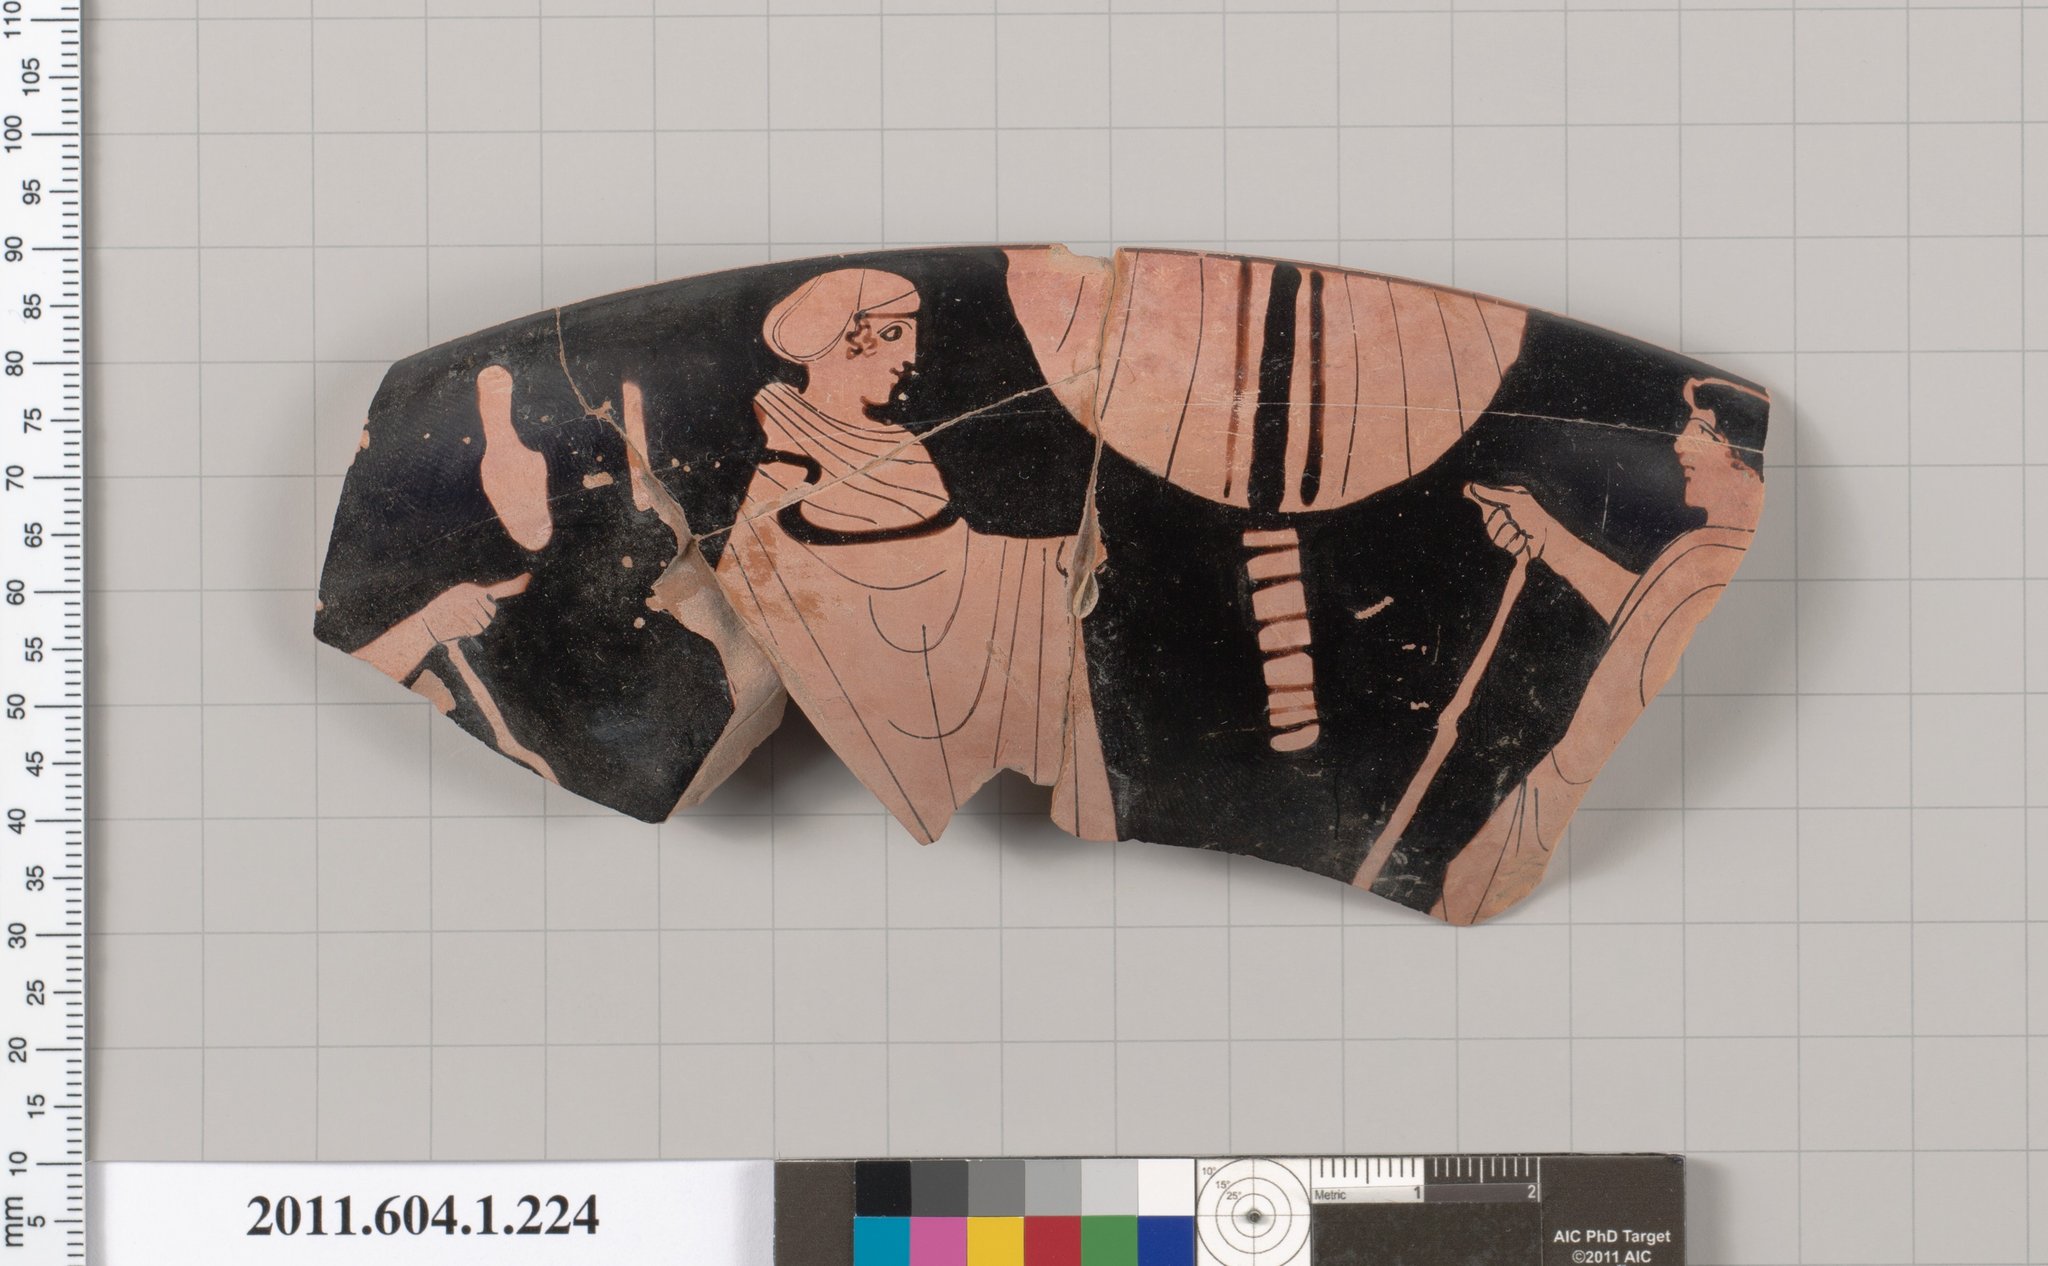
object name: kylix fragment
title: Terracotta rim fragment of a kylix (drinking cup)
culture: greek, attic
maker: painter of brussels r 330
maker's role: artist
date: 475-451 BCE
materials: terracotta